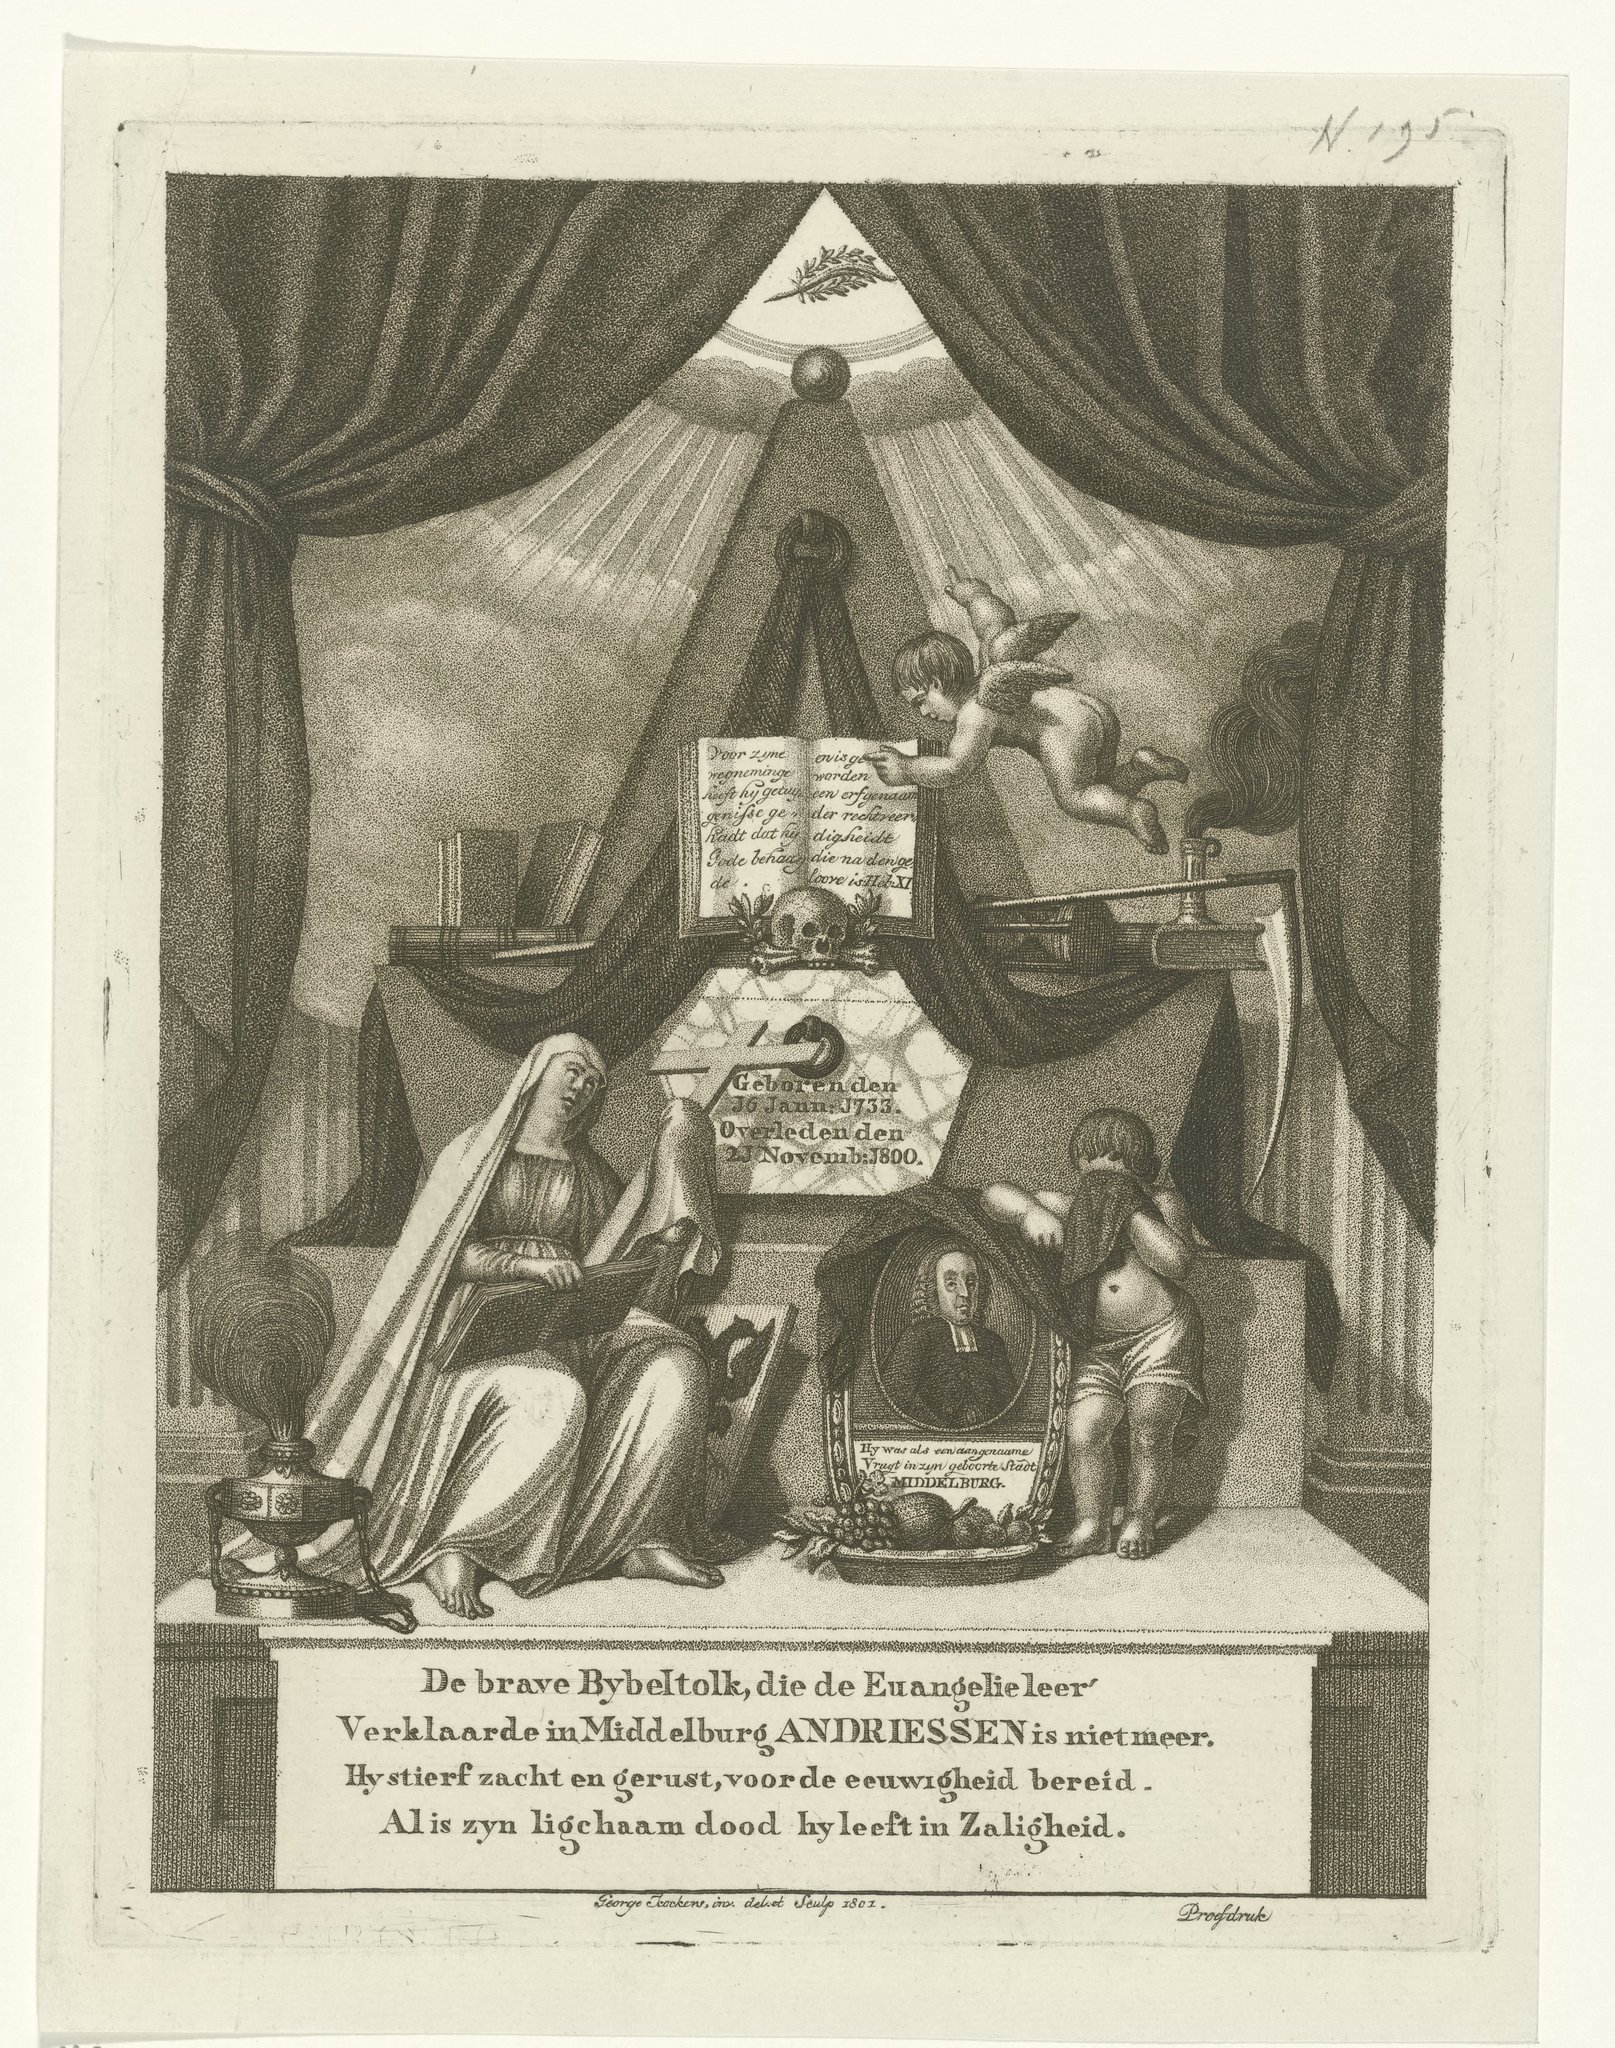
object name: print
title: Allegorische compositie op de dood van predikant Andreas Andriessen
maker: george kockers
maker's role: goldsmith, print maker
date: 1801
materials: paper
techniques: etching, engraving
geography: middelburg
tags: the hague, middelburg, the virgin mary, (human) skull, book - mm - book open, hourglass, other allegories of time, e.g. 'tempo' (ripa)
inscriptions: collector's mark: Lugt 2760, collector's mark: Lugt 2228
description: Allegorische compositie op de dood van Andreas Andriessen, predikant en hoogleraar te Middelburg. Rechts op het grafmonument is zijn portret in een ovale omlijsting weergegeven, geflankeerd door een huilend kind en een biddende Maria met een bijbel en een kruis op haar schoot. Op het monument liggen onder andere boeken, een schedel, een zandloper een zeis. Onder de afbeelding een plaquette met een vierregelig vers.